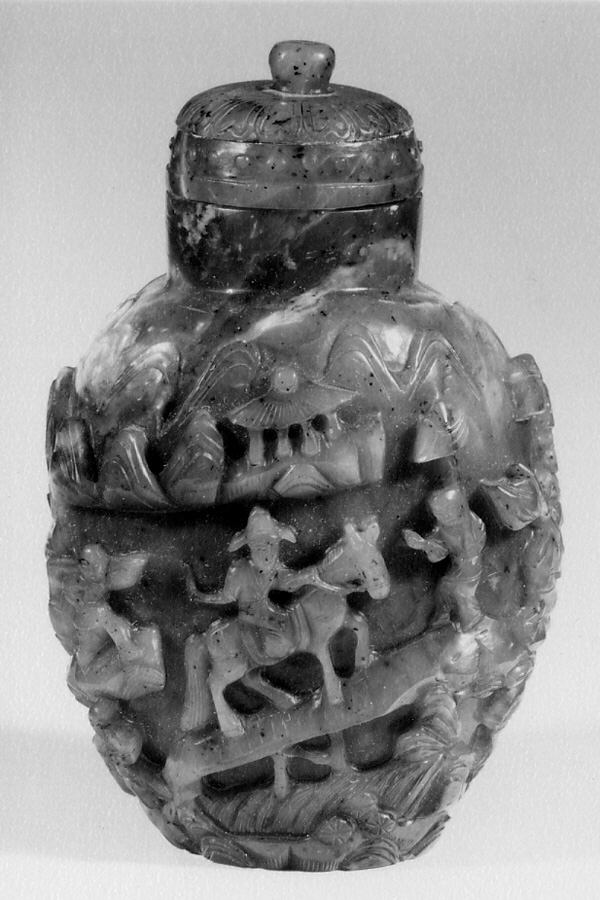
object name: snuff bottle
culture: chinese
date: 1801-1900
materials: jade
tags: human figures,horses